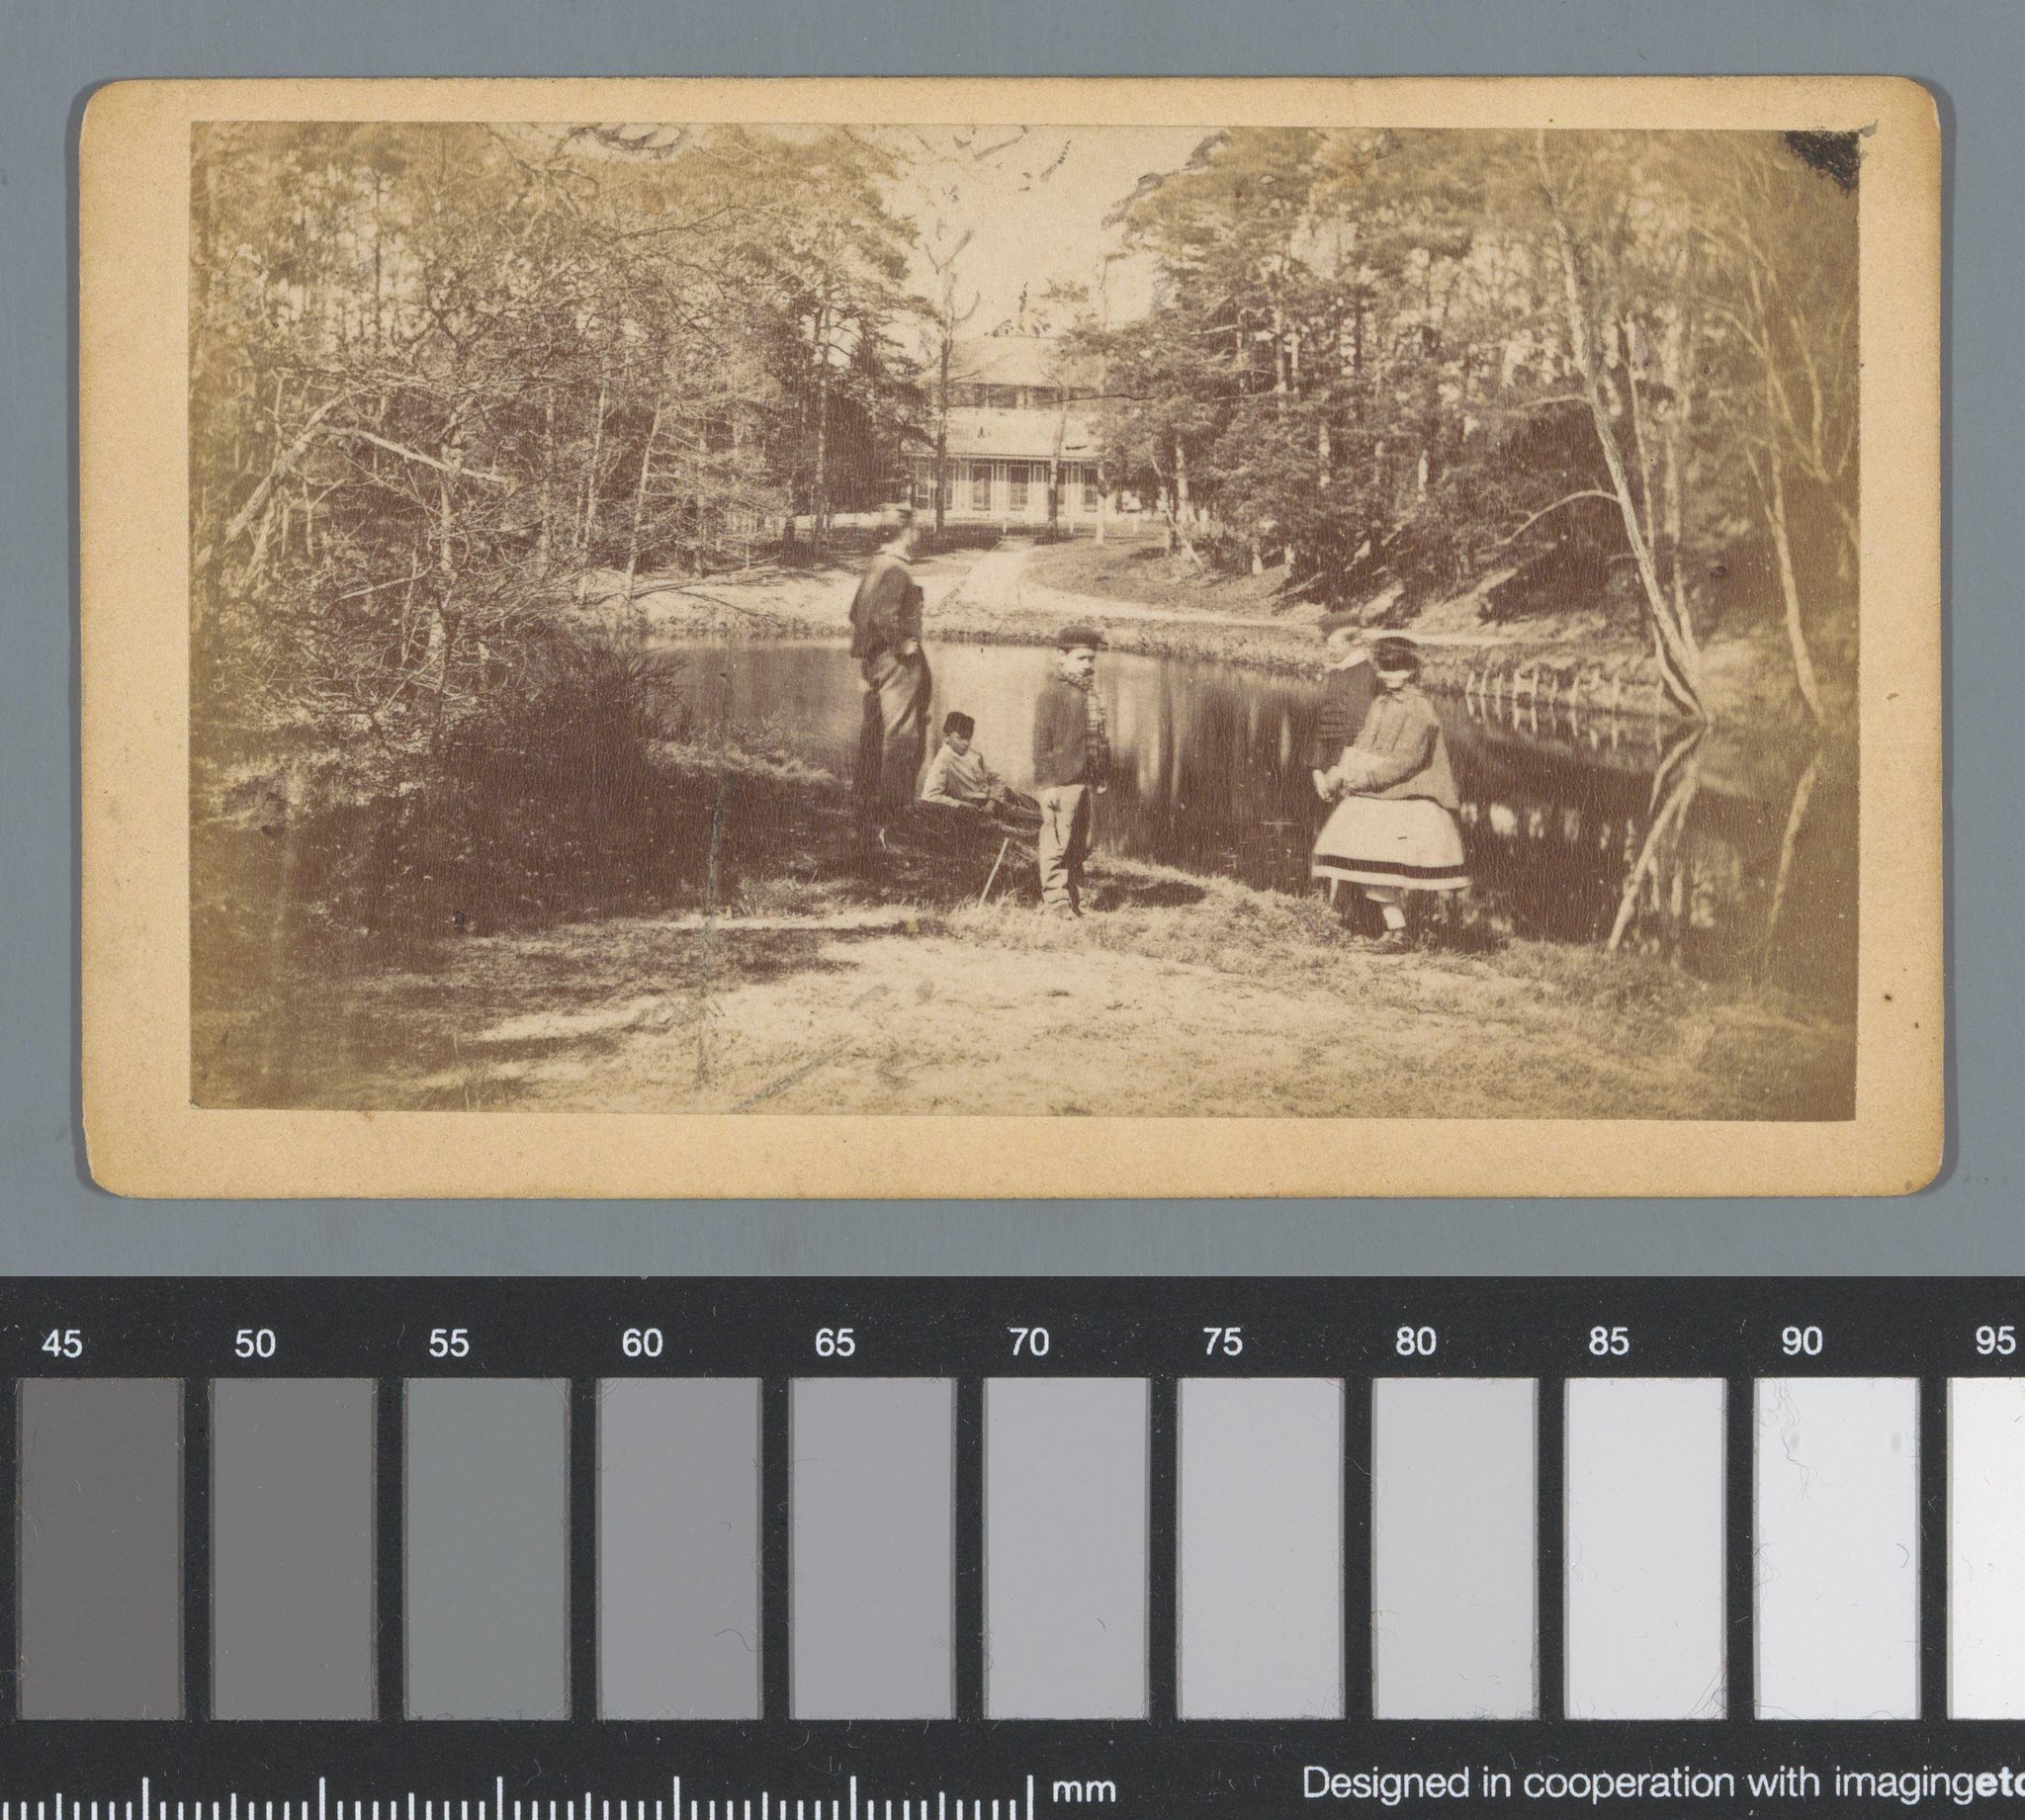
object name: carte de visite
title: Gezicht op de Pekingkom te Baarn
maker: jan ebbenhorst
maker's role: painter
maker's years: 1812-1883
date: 1850-1900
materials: cardboard, photographic support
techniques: albumen print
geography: baarn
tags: garden pond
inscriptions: inscription: ‘Peeking en de peeking kom, villa in Baarn’, number: ‘No 35’